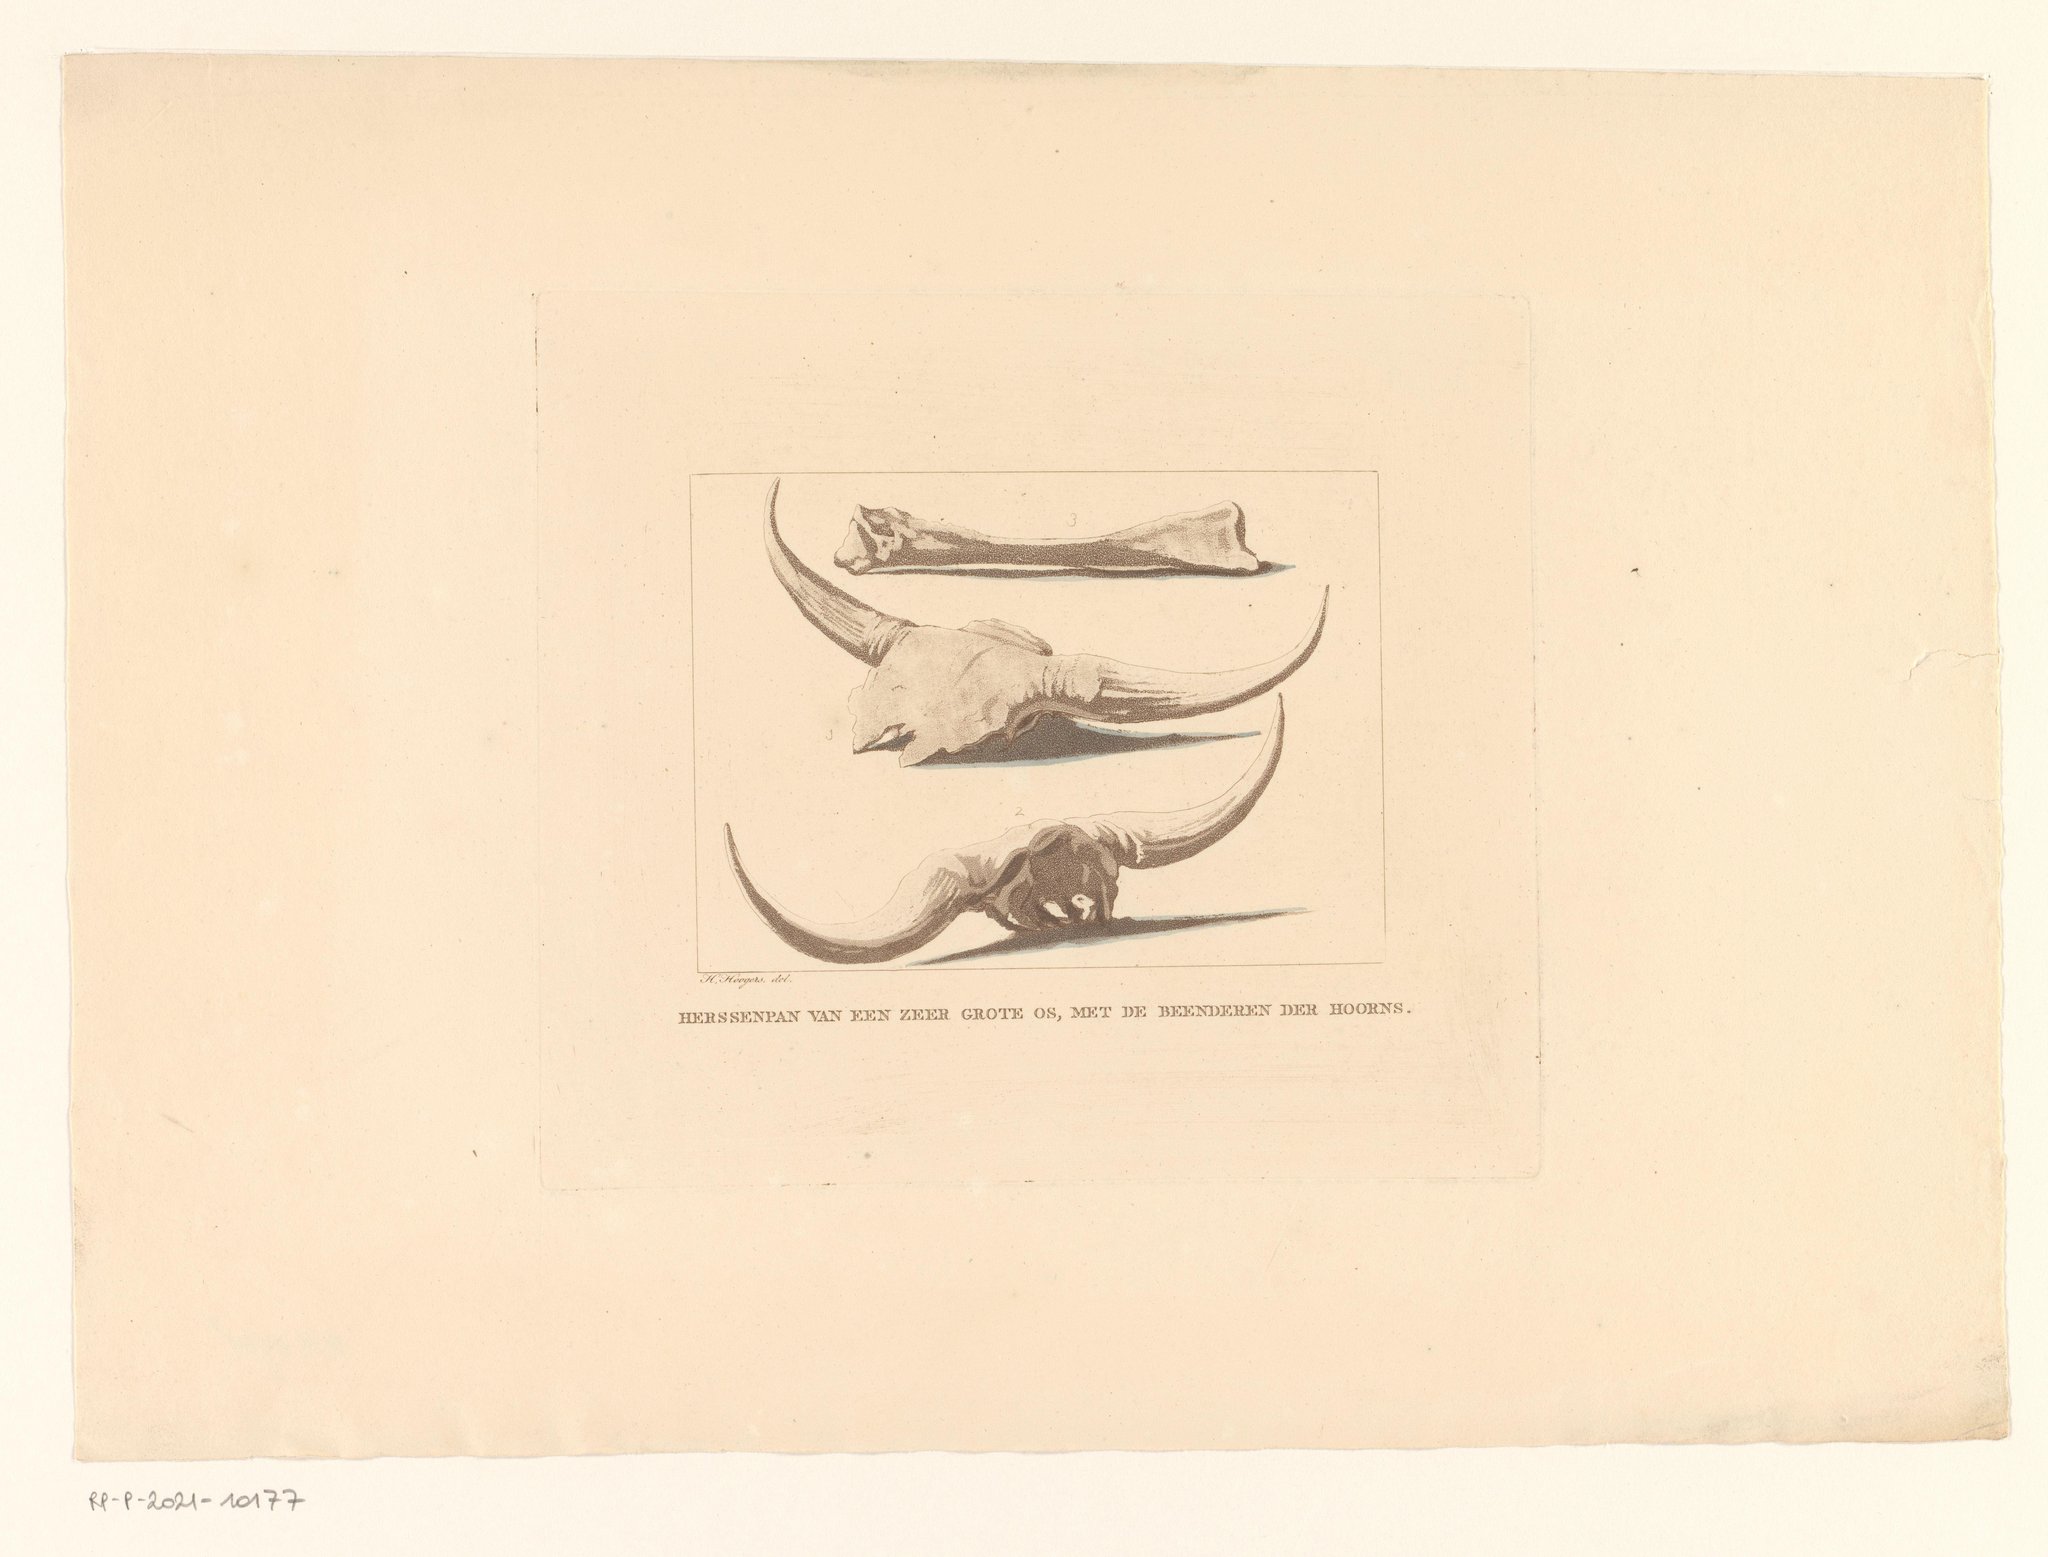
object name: print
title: Fossiele beenderen van een oeros, gevonden tijdens de watersnood, 1809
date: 1809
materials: paper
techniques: aquatint, etching, hand coloring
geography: netherlands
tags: fossil animals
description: Prent waarschijnlijk uit: Ewijk, Hendrik. Geschiedkundig verslag der dijkbreuken en overstroomingen, langs de rivieren in het Koningrijk Holland, voorgevallen in louwmaand MDCCCIX. 3 dln. Amsterdam: Johannes Allart en Jacobus Ruys, 1809.